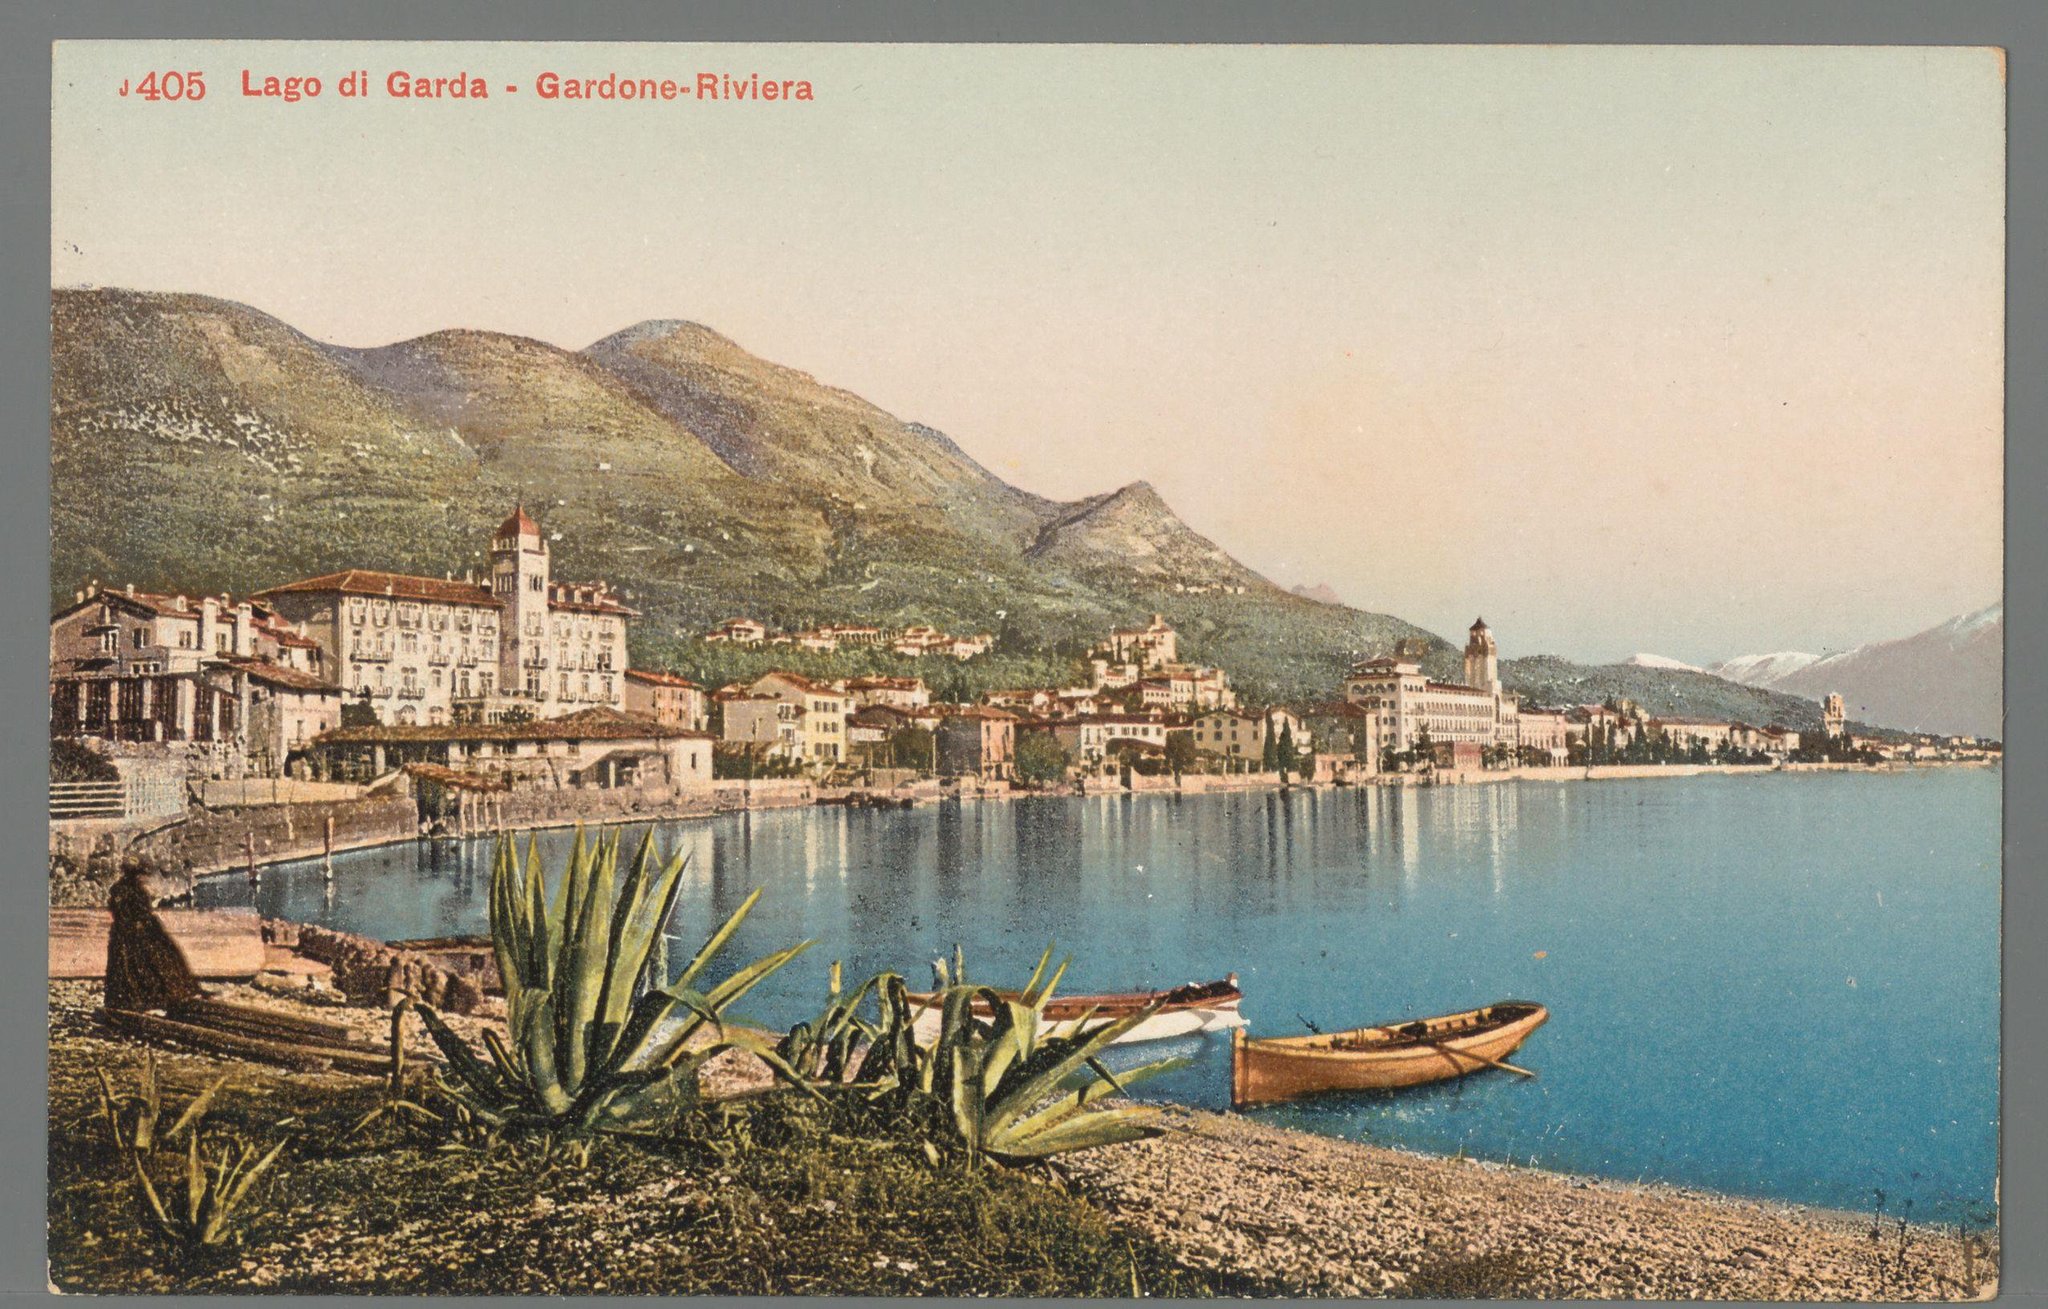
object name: ansichtkaart, prentbriefkaart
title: Lago di Garda. Gardona-Riviera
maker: Anonymous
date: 1905-1930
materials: cardboard, photographic process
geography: zurich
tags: prospect of village, silhouette of village, lake, mountains